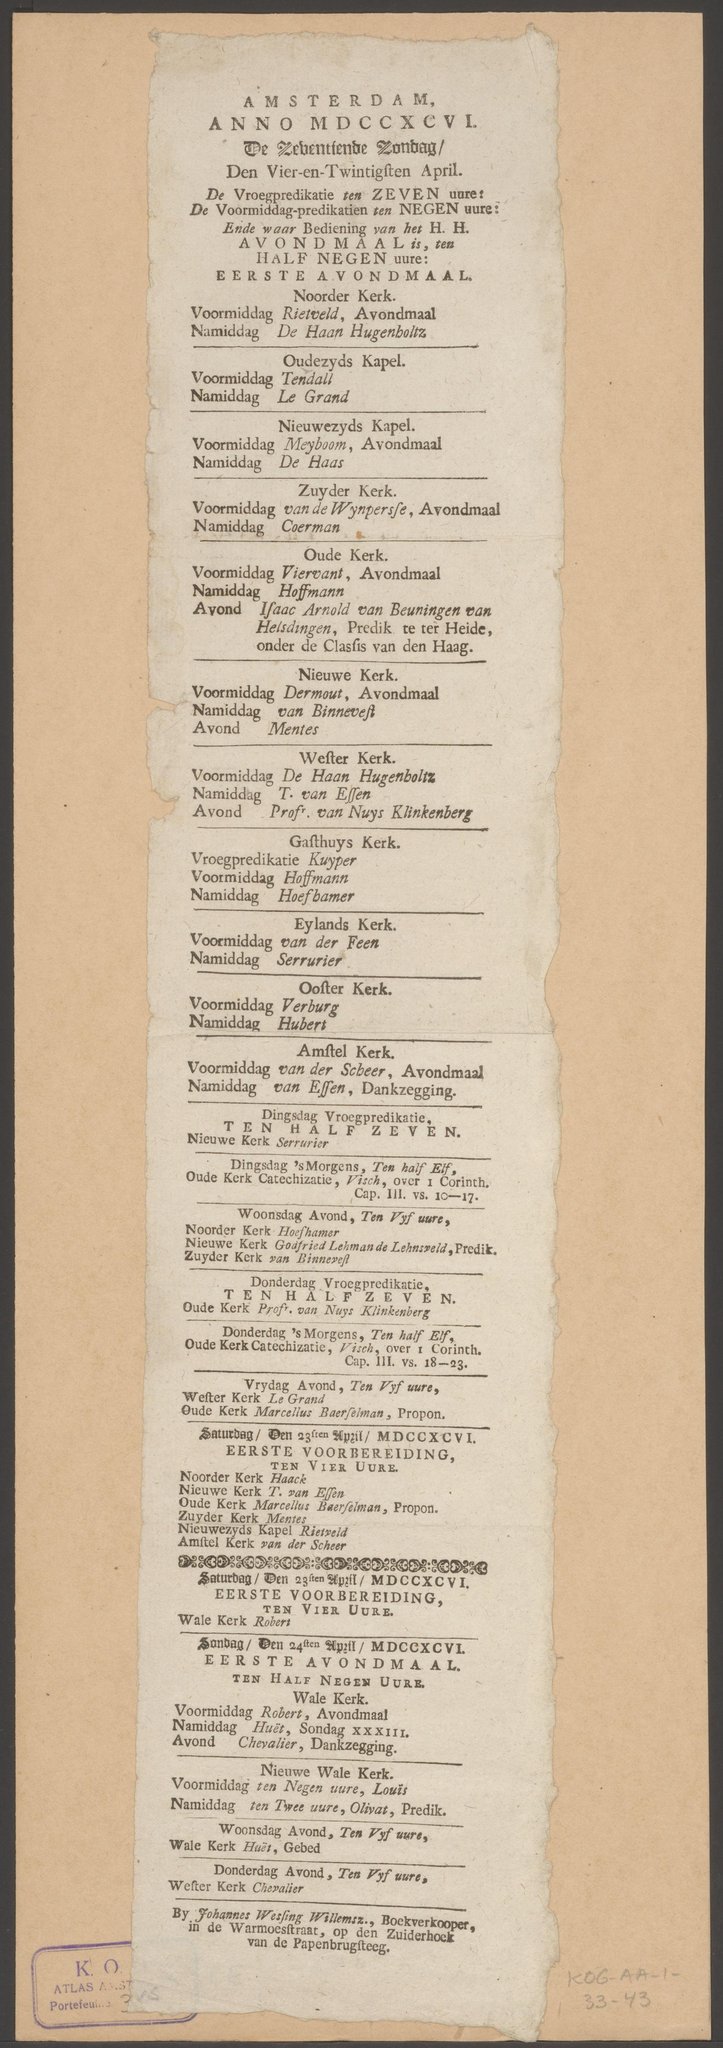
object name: list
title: Lijst met predikbeurten te Amsterdam in de week van 24 april 1796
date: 1704-1796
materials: paper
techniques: letterpress printing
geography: amsterdam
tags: preaching (in general)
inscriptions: collector's mark: Lugt 1641b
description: Onderwerpsrubriek binnen de Atlas Amsterdam: Kerkwezen: Hervormde Gemeente: Predikbeurtenlijsten 1814, 1867.